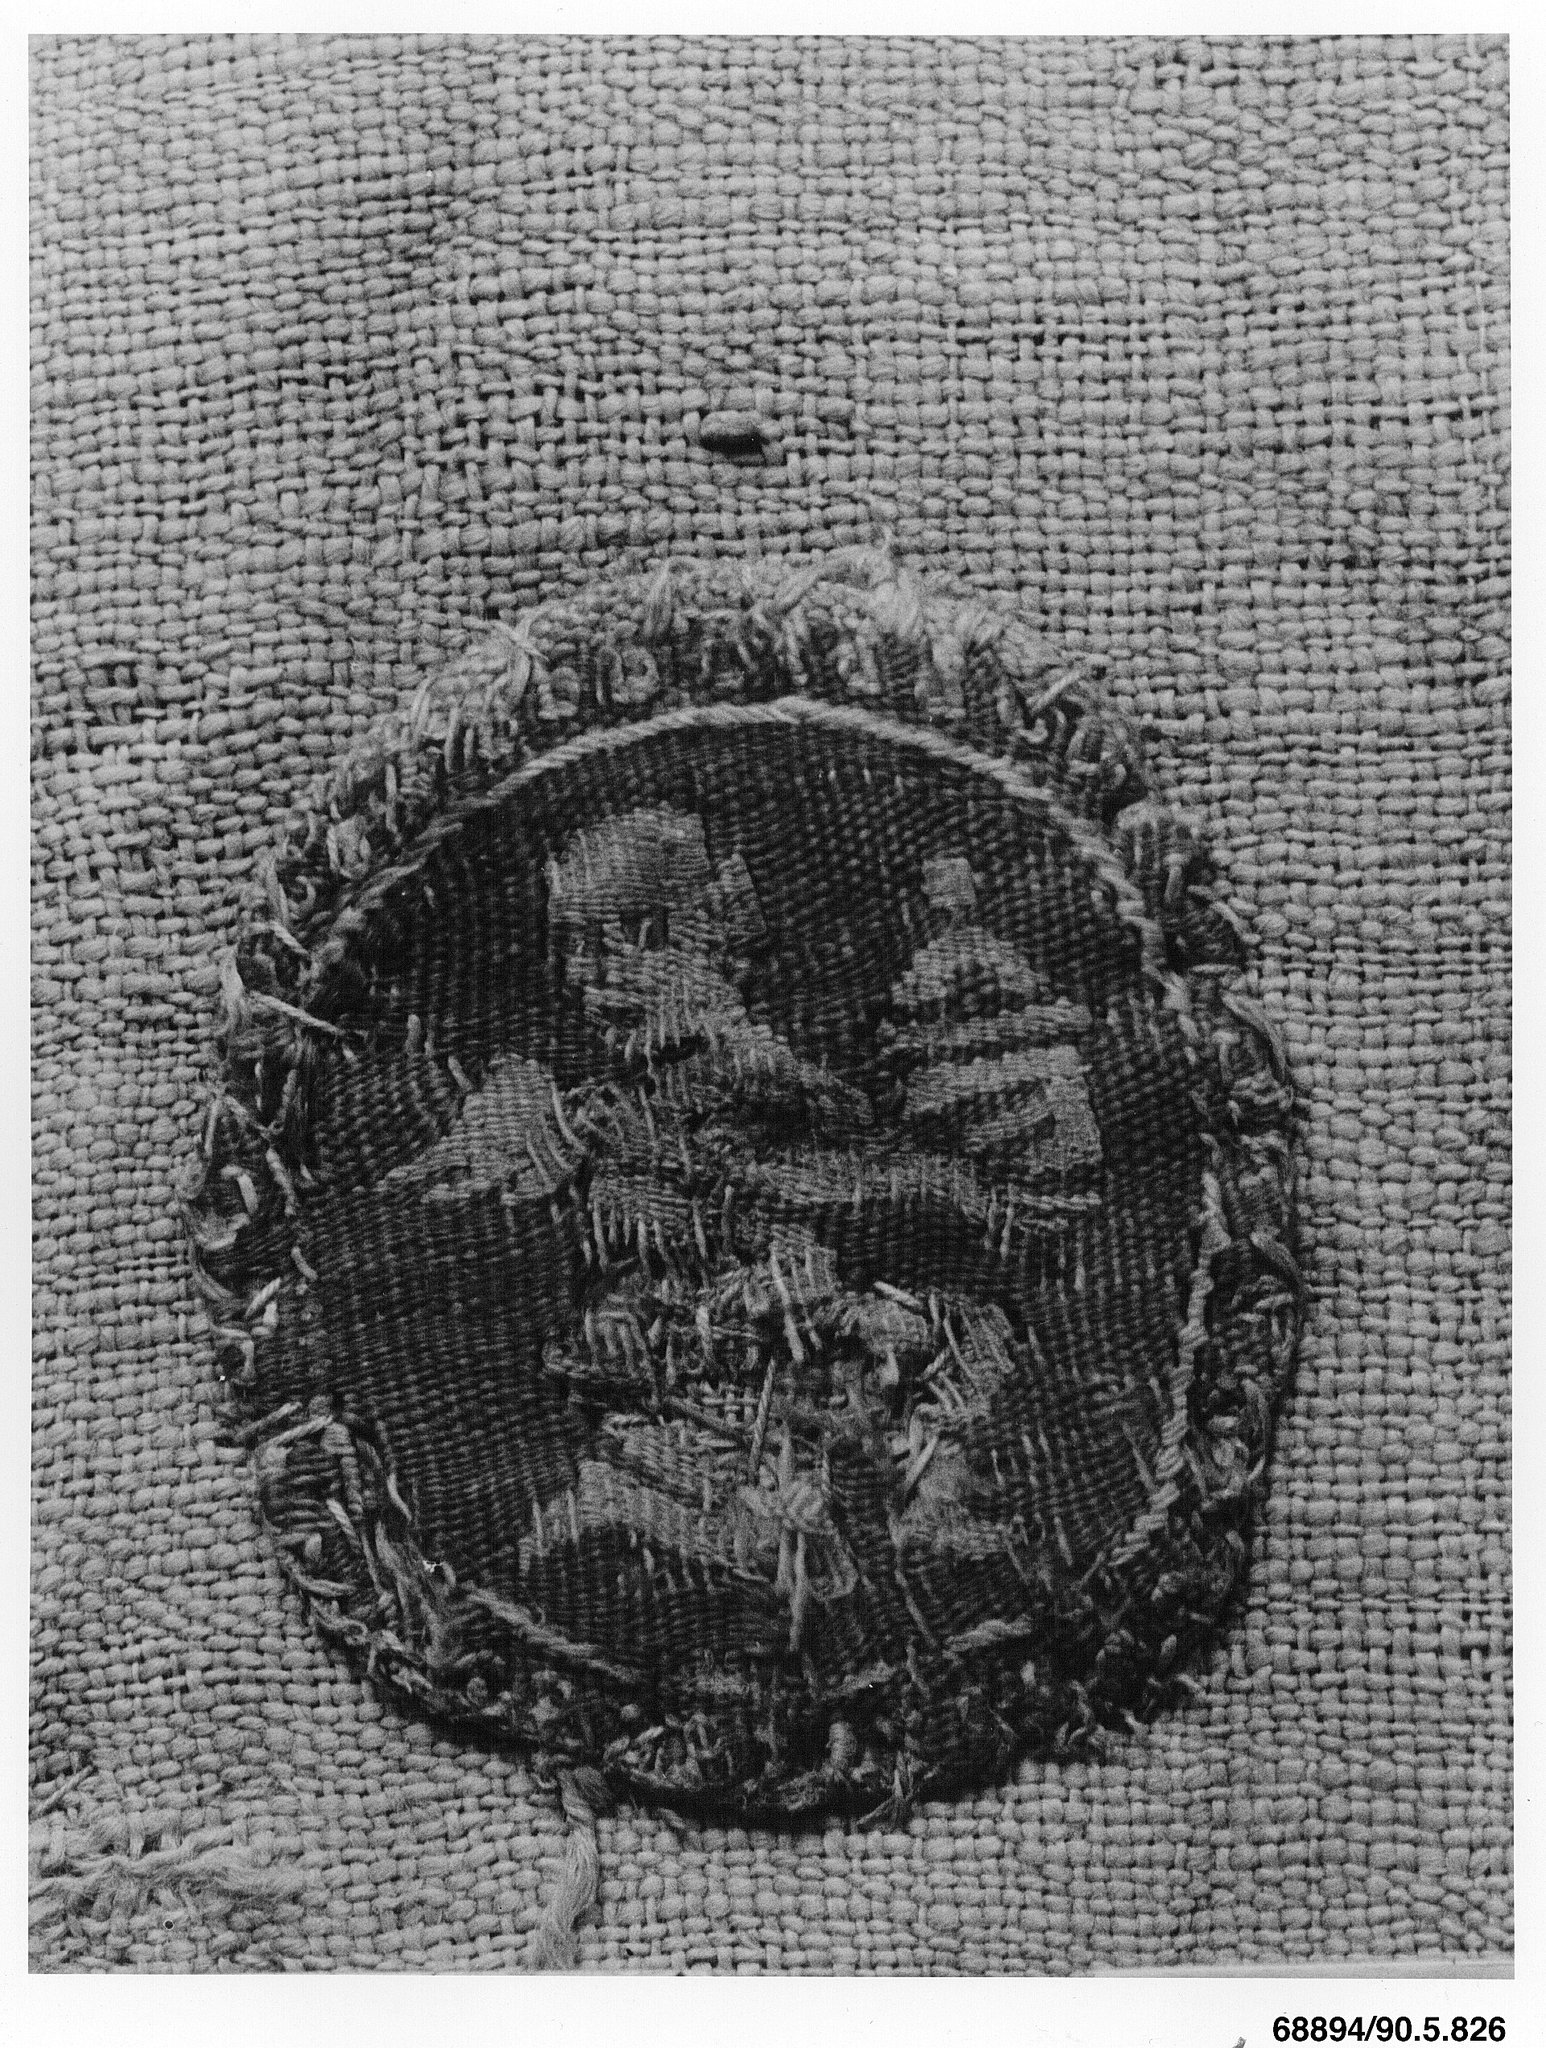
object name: textile fragment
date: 201-300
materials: linen, wool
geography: egypt